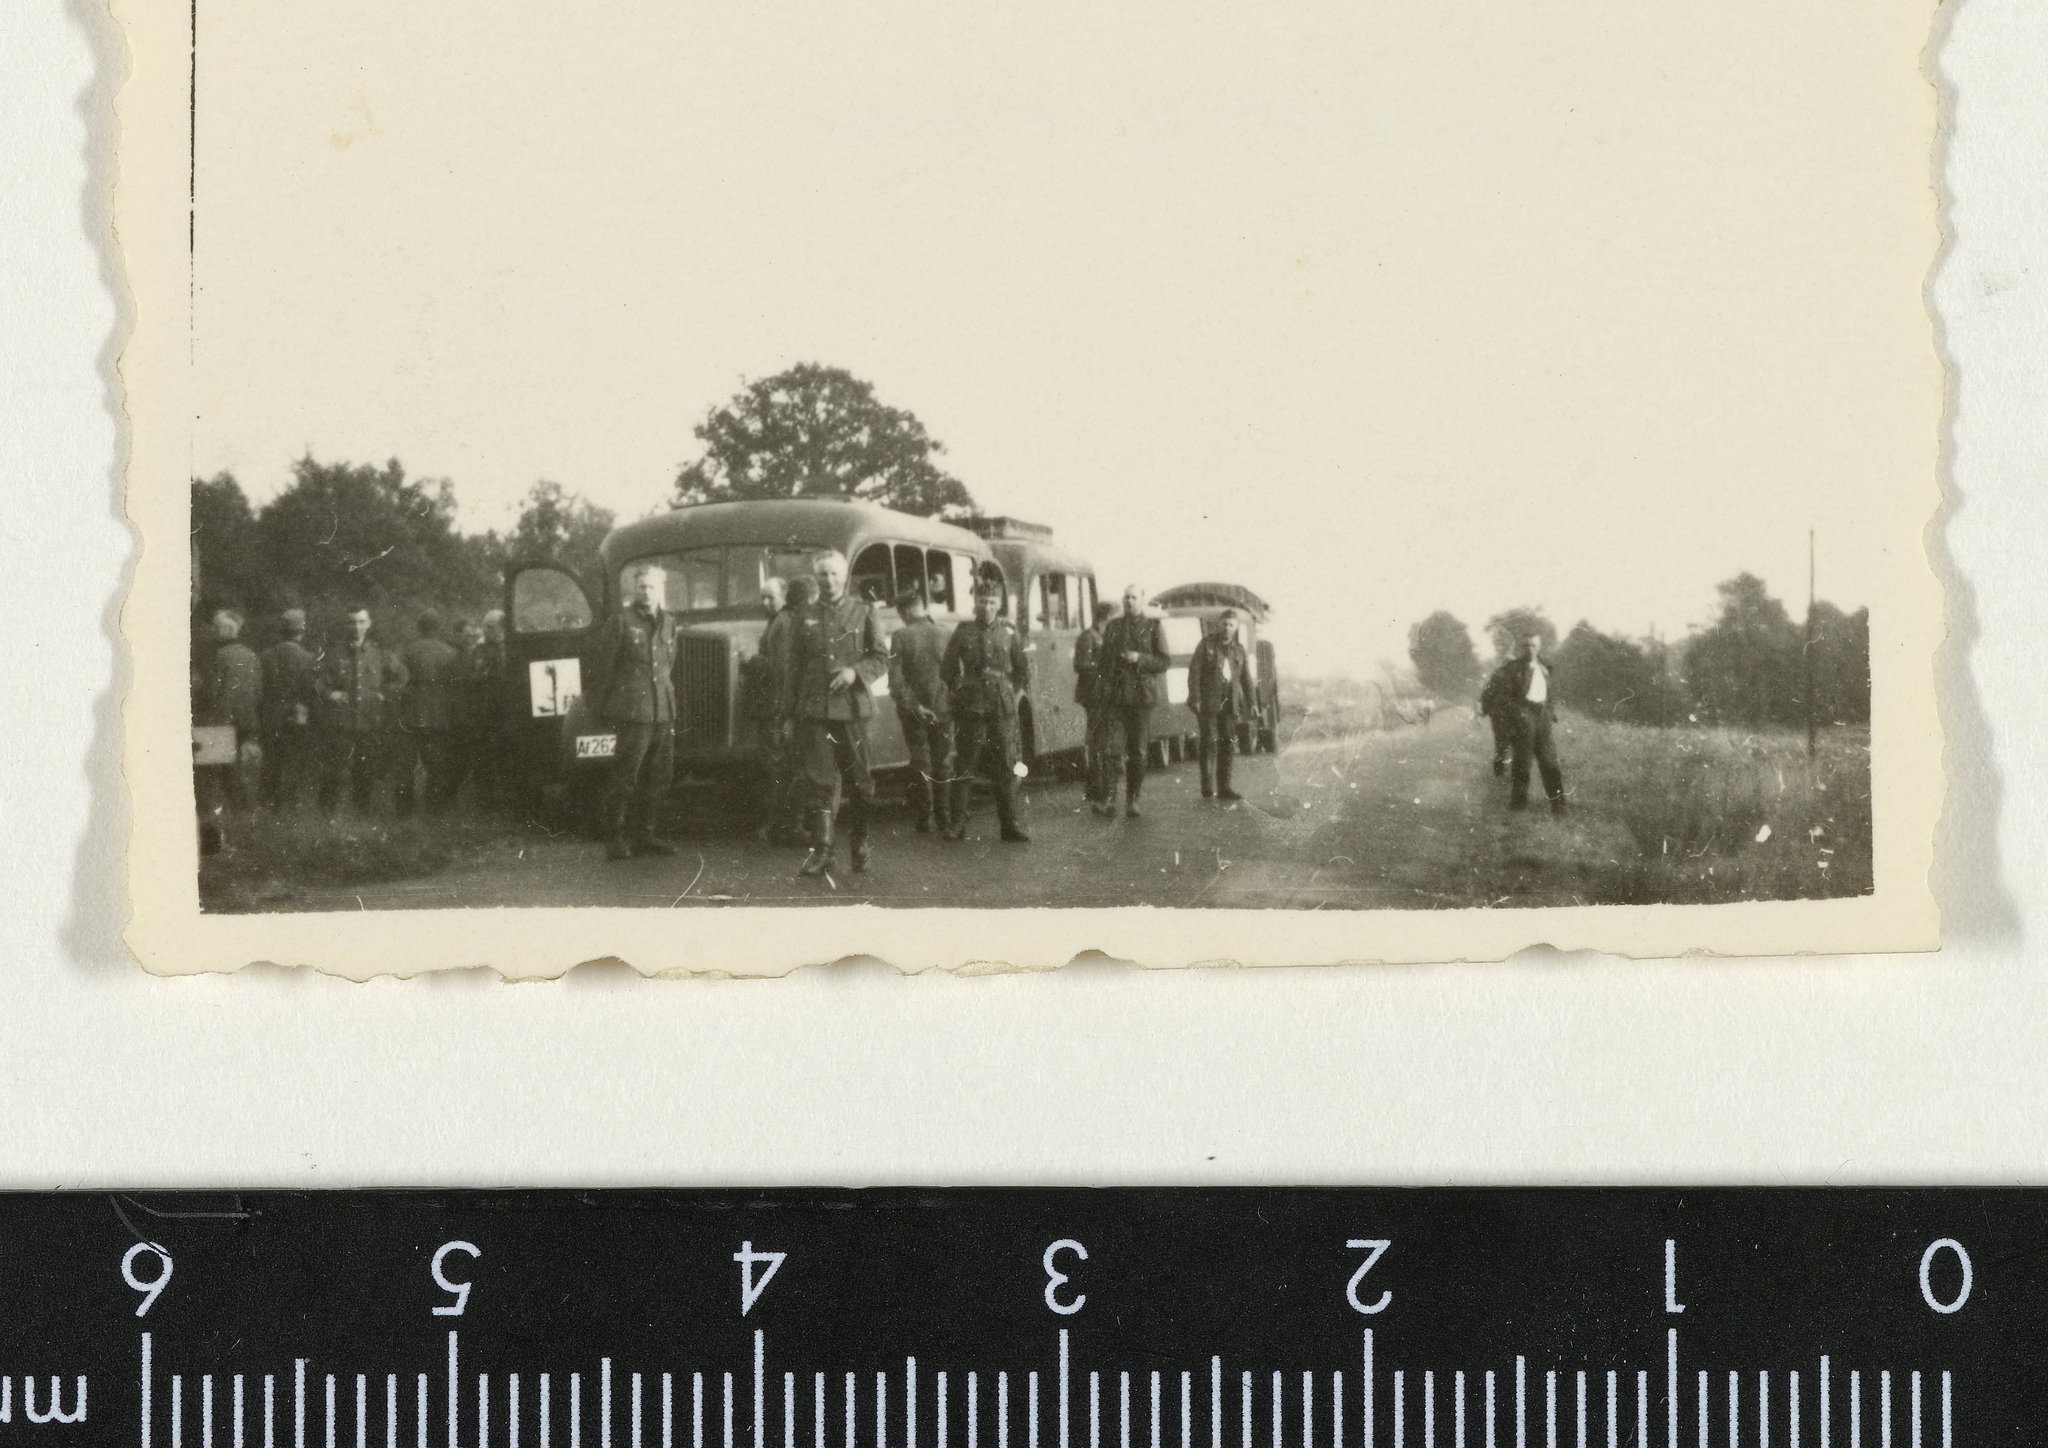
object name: photograph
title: Duitse militairen bij twee bussen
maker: Anonymous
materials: photographic support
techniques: gelatin silver print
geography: france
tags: troop movements, transportation, occupation ~ war, france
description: Duitse militairen staan op een weg bij twee bussen. Achterop staat: Zurück nach Orléans von Vierzon.